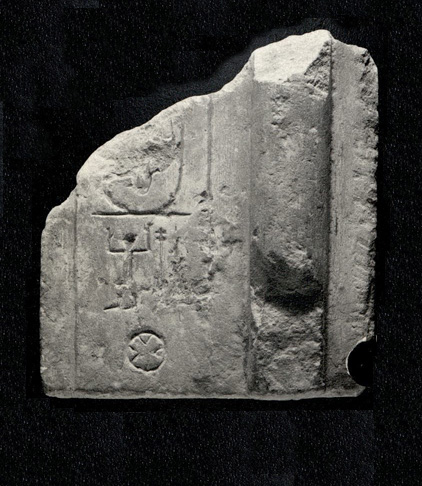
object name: fragment, stela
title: Fragment of stela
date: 1981-1640 BCE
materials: limestone, paint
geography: egypt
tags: cartouches,hieroglyphs